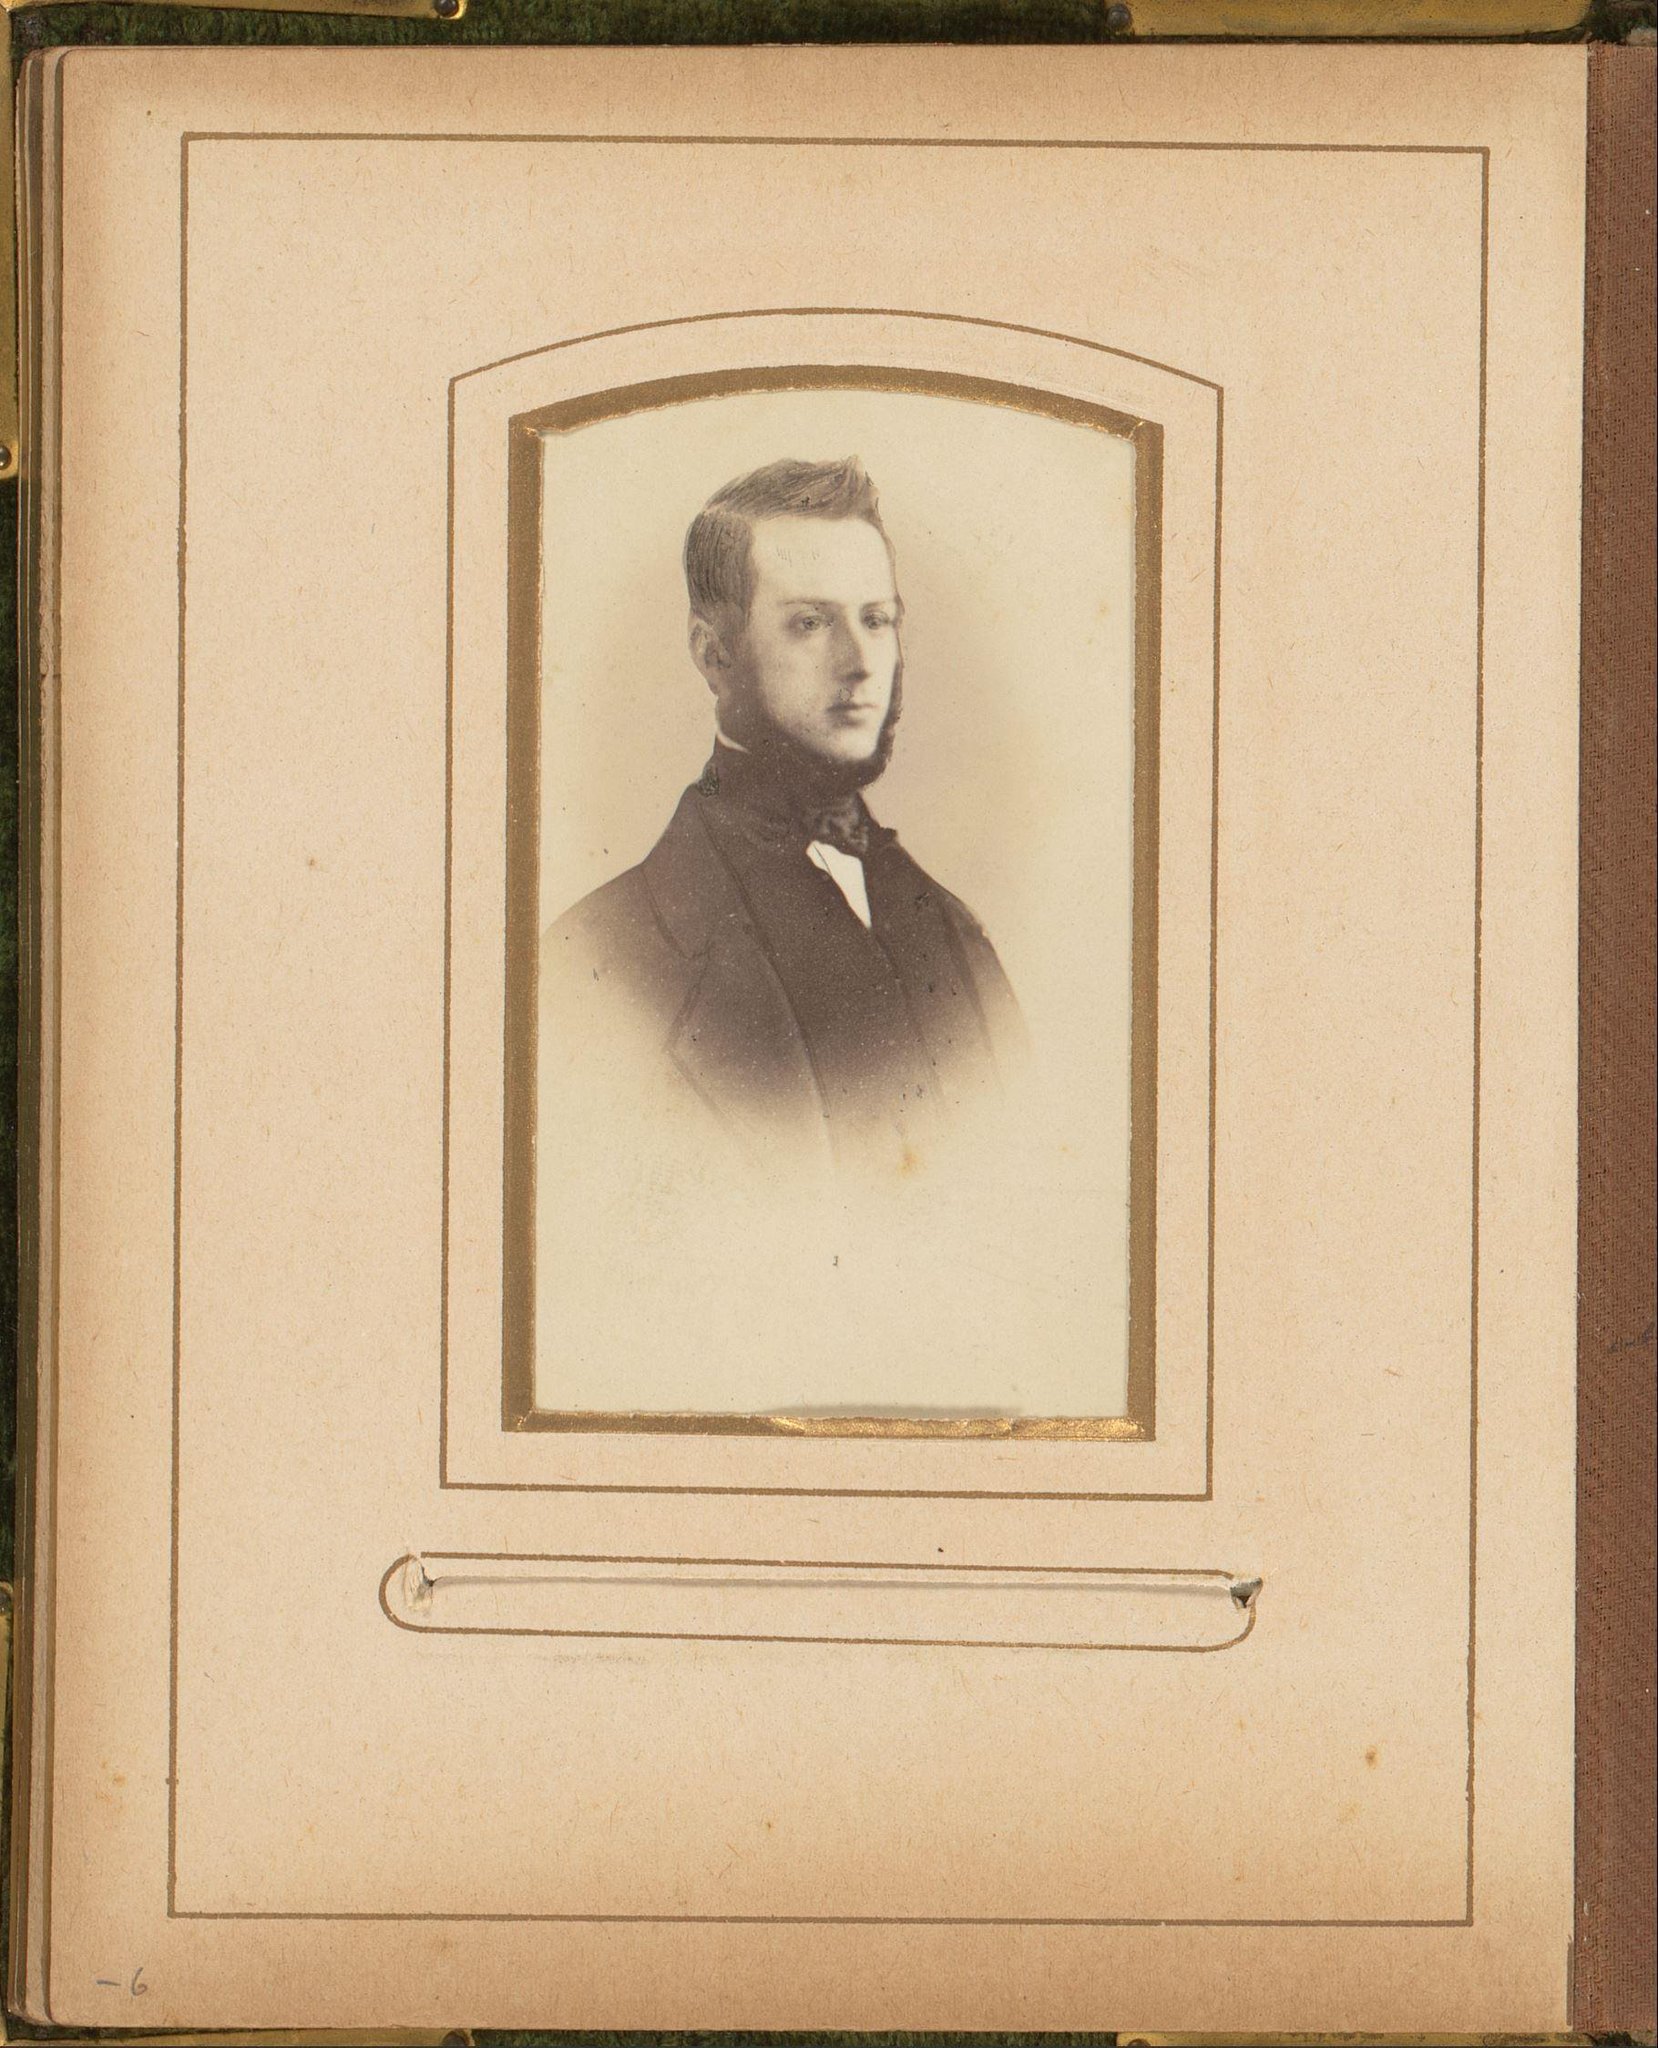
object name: photograph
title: Portret van een man, mogelijk een lid van de familie Beucker Andreae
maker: Anonymous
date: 1854-1885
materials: cardboard, paper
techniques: albumen print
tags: adult man, anonymous historical person portrayed